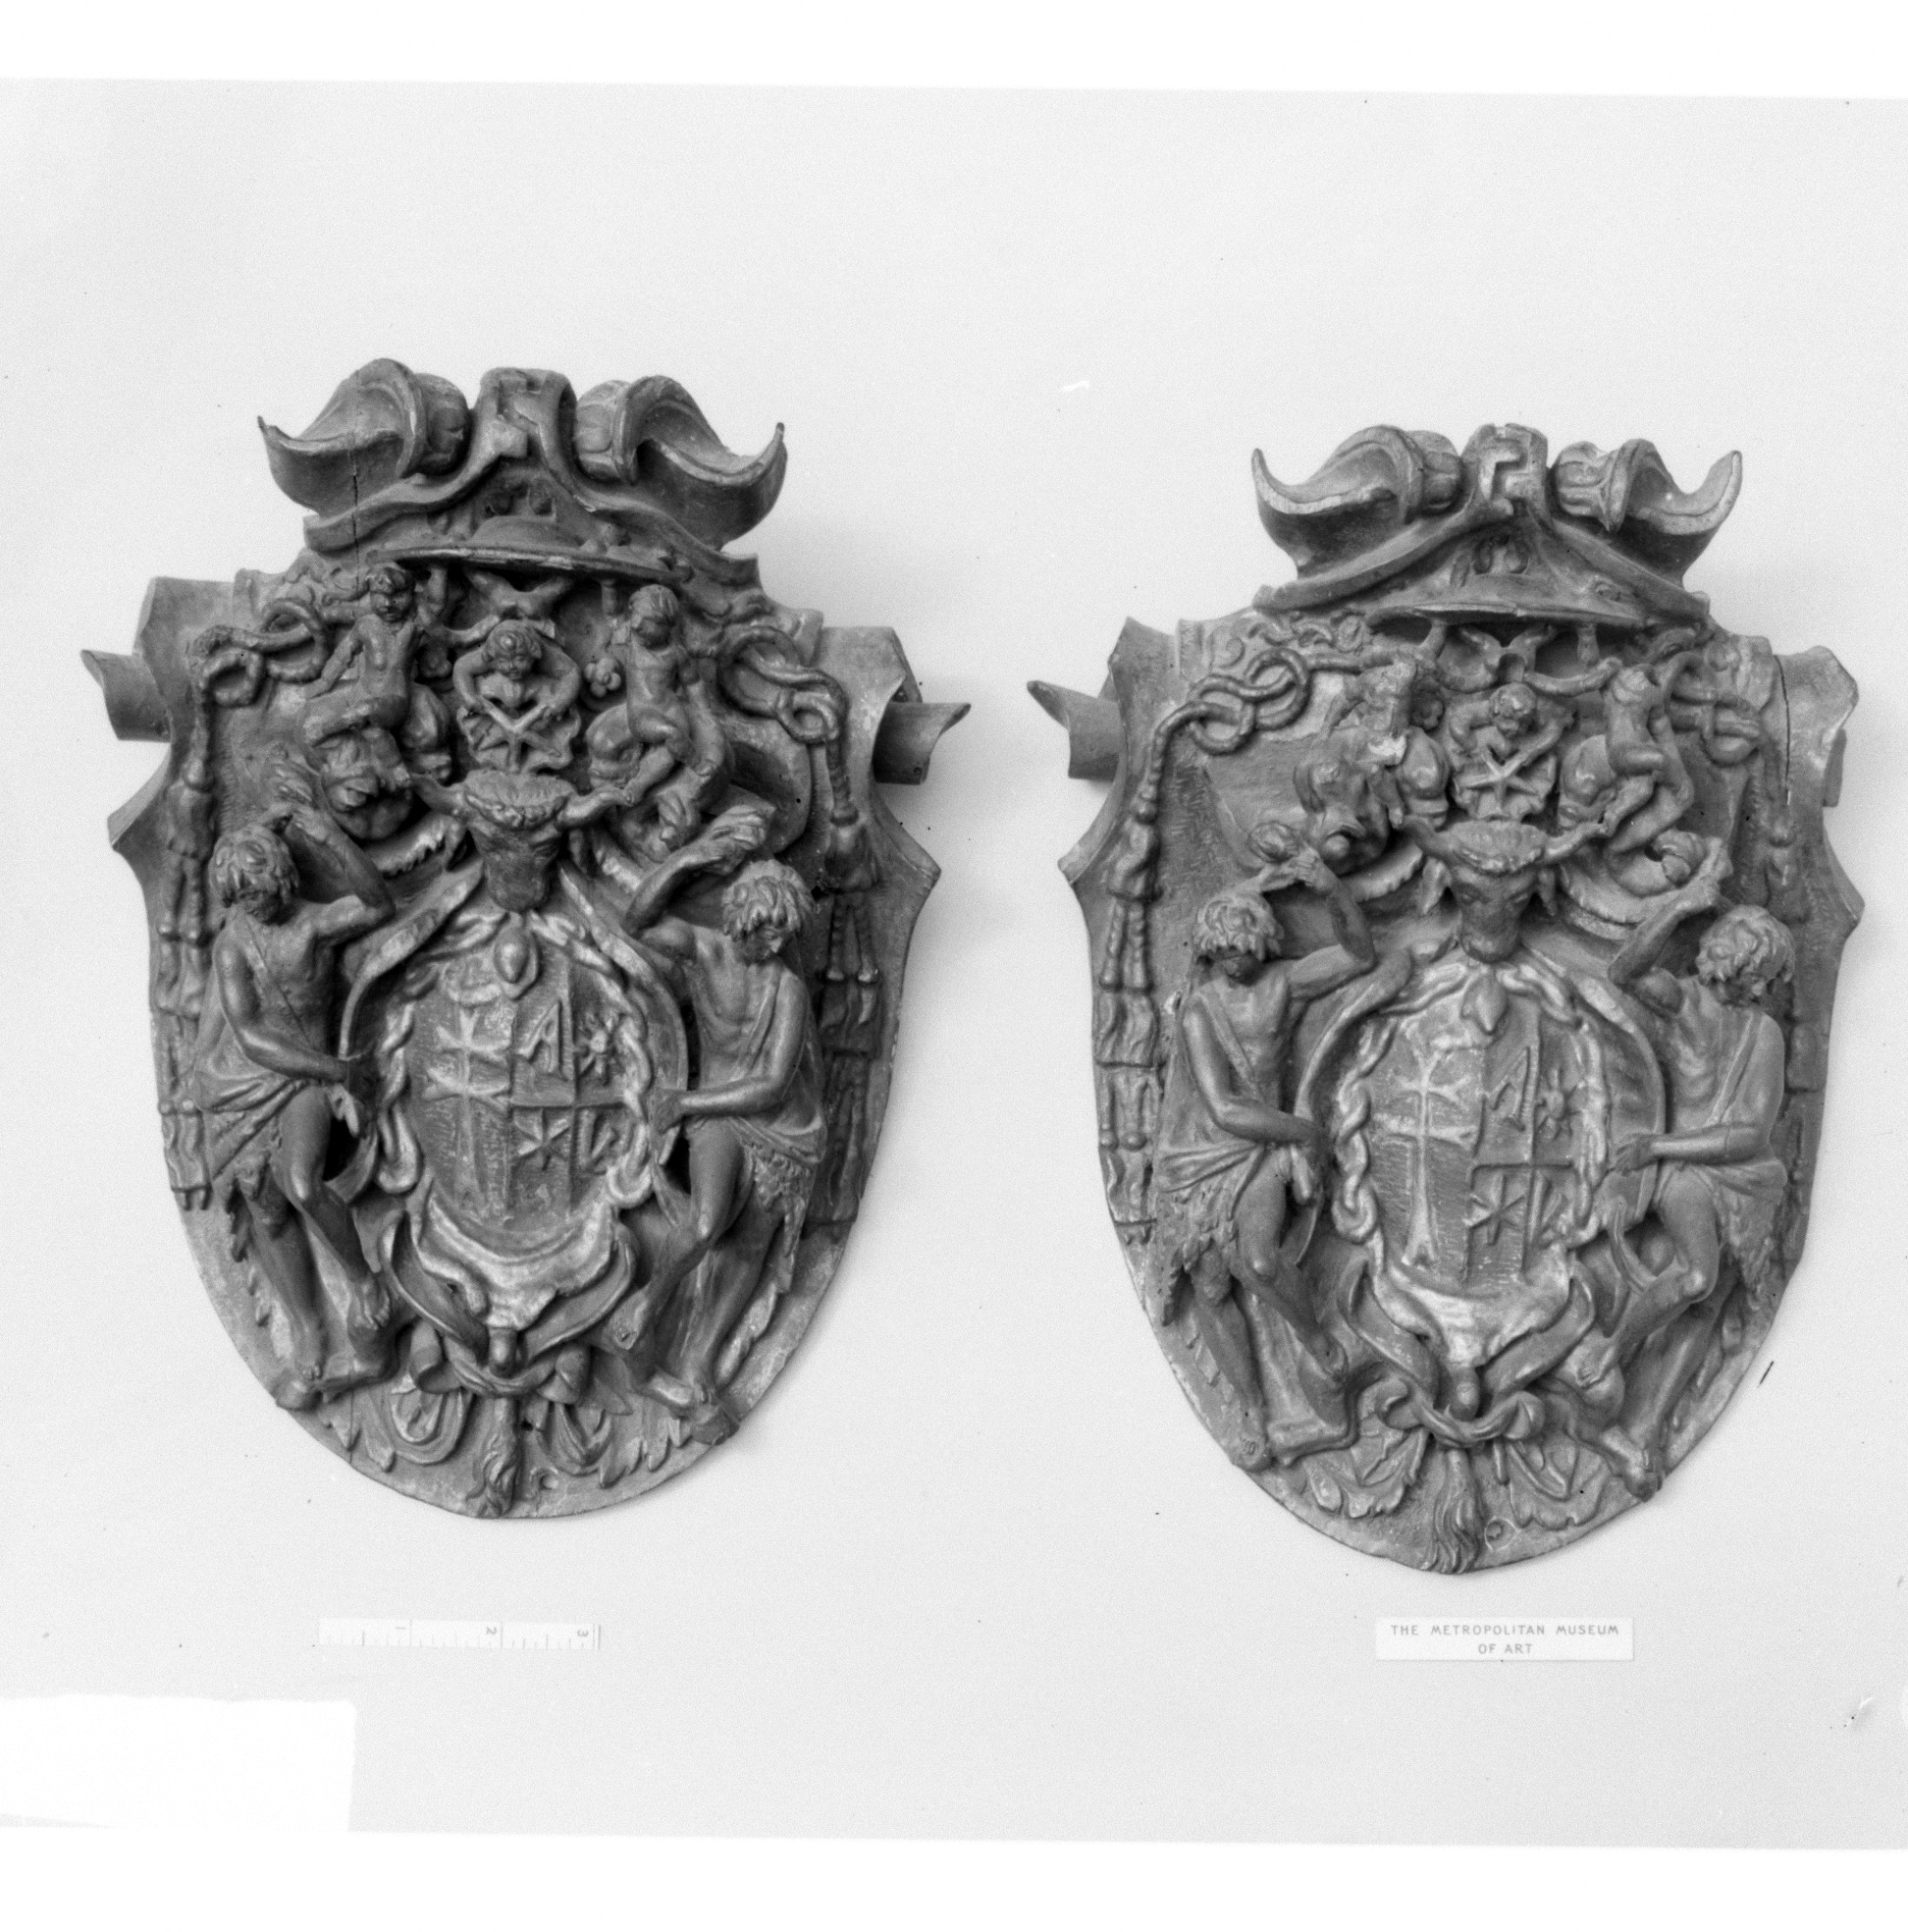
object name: cartouch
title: Pair of cartouches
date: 1567-1600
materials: wood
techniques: carving, gilding, painting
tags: men,bulls,coat of arms